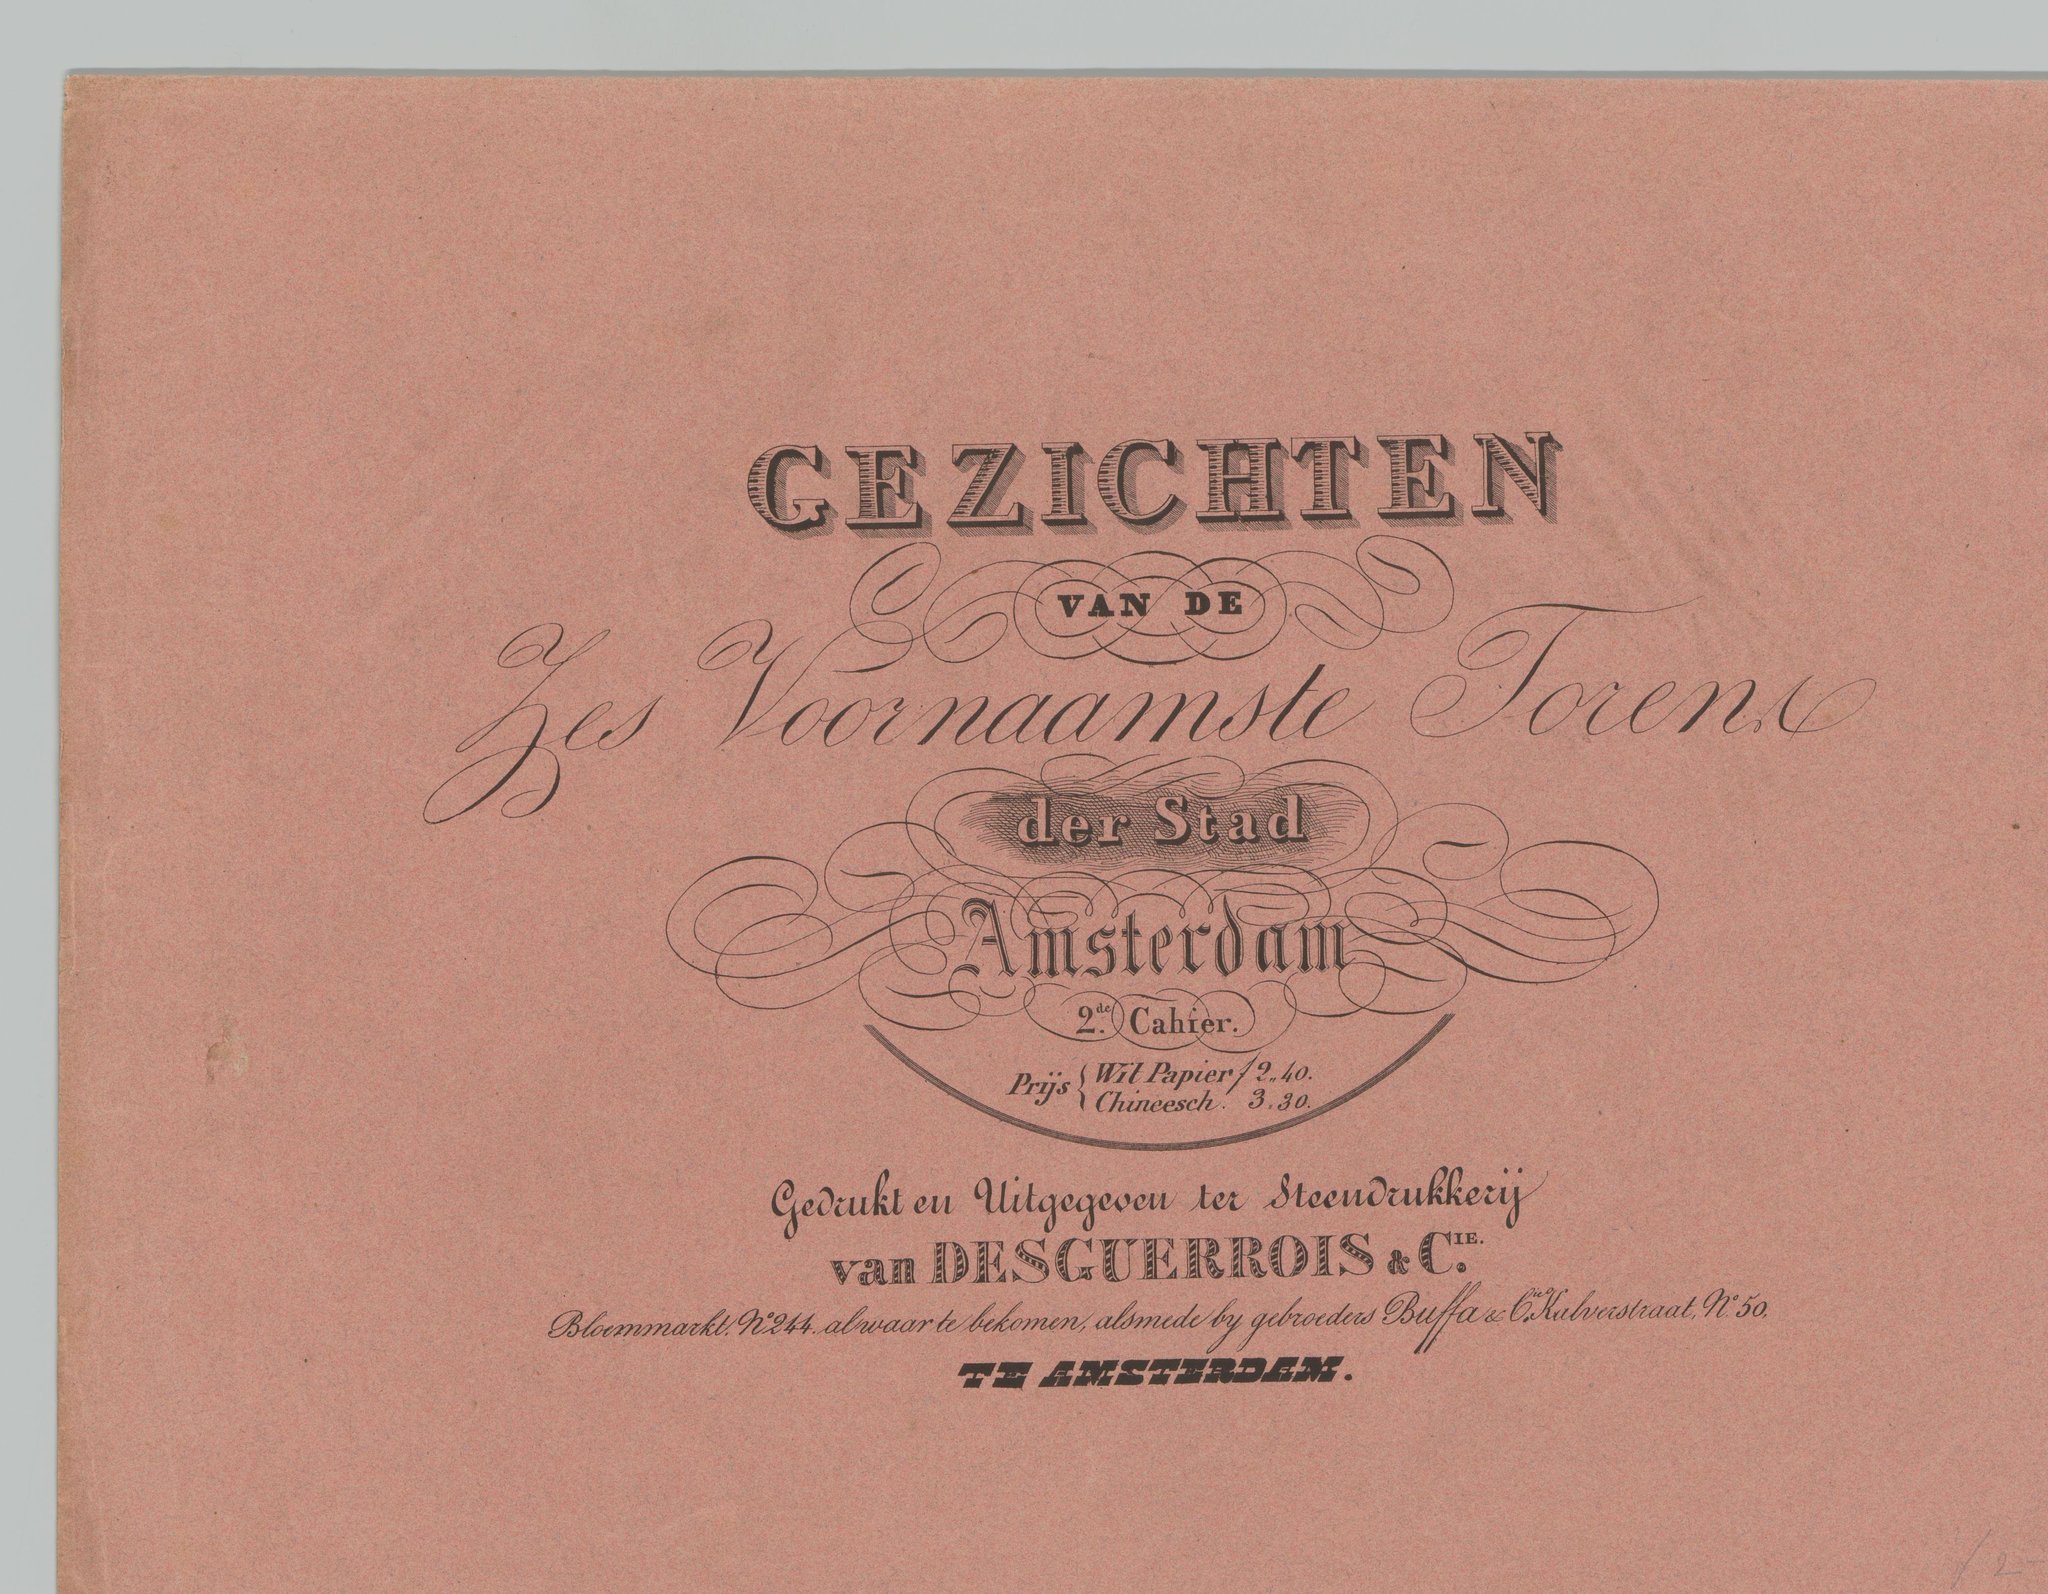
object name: wrapper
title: Omslag met serie Amsterdamse torens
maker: Anonymous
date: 1828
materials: paper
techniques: hand coloring, lithograph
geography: amsterdam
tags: tower, clock tower ~ monumental adornment, amsterdam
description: Omslag met een serie van zes lithografieën van Amsterdamse torens.